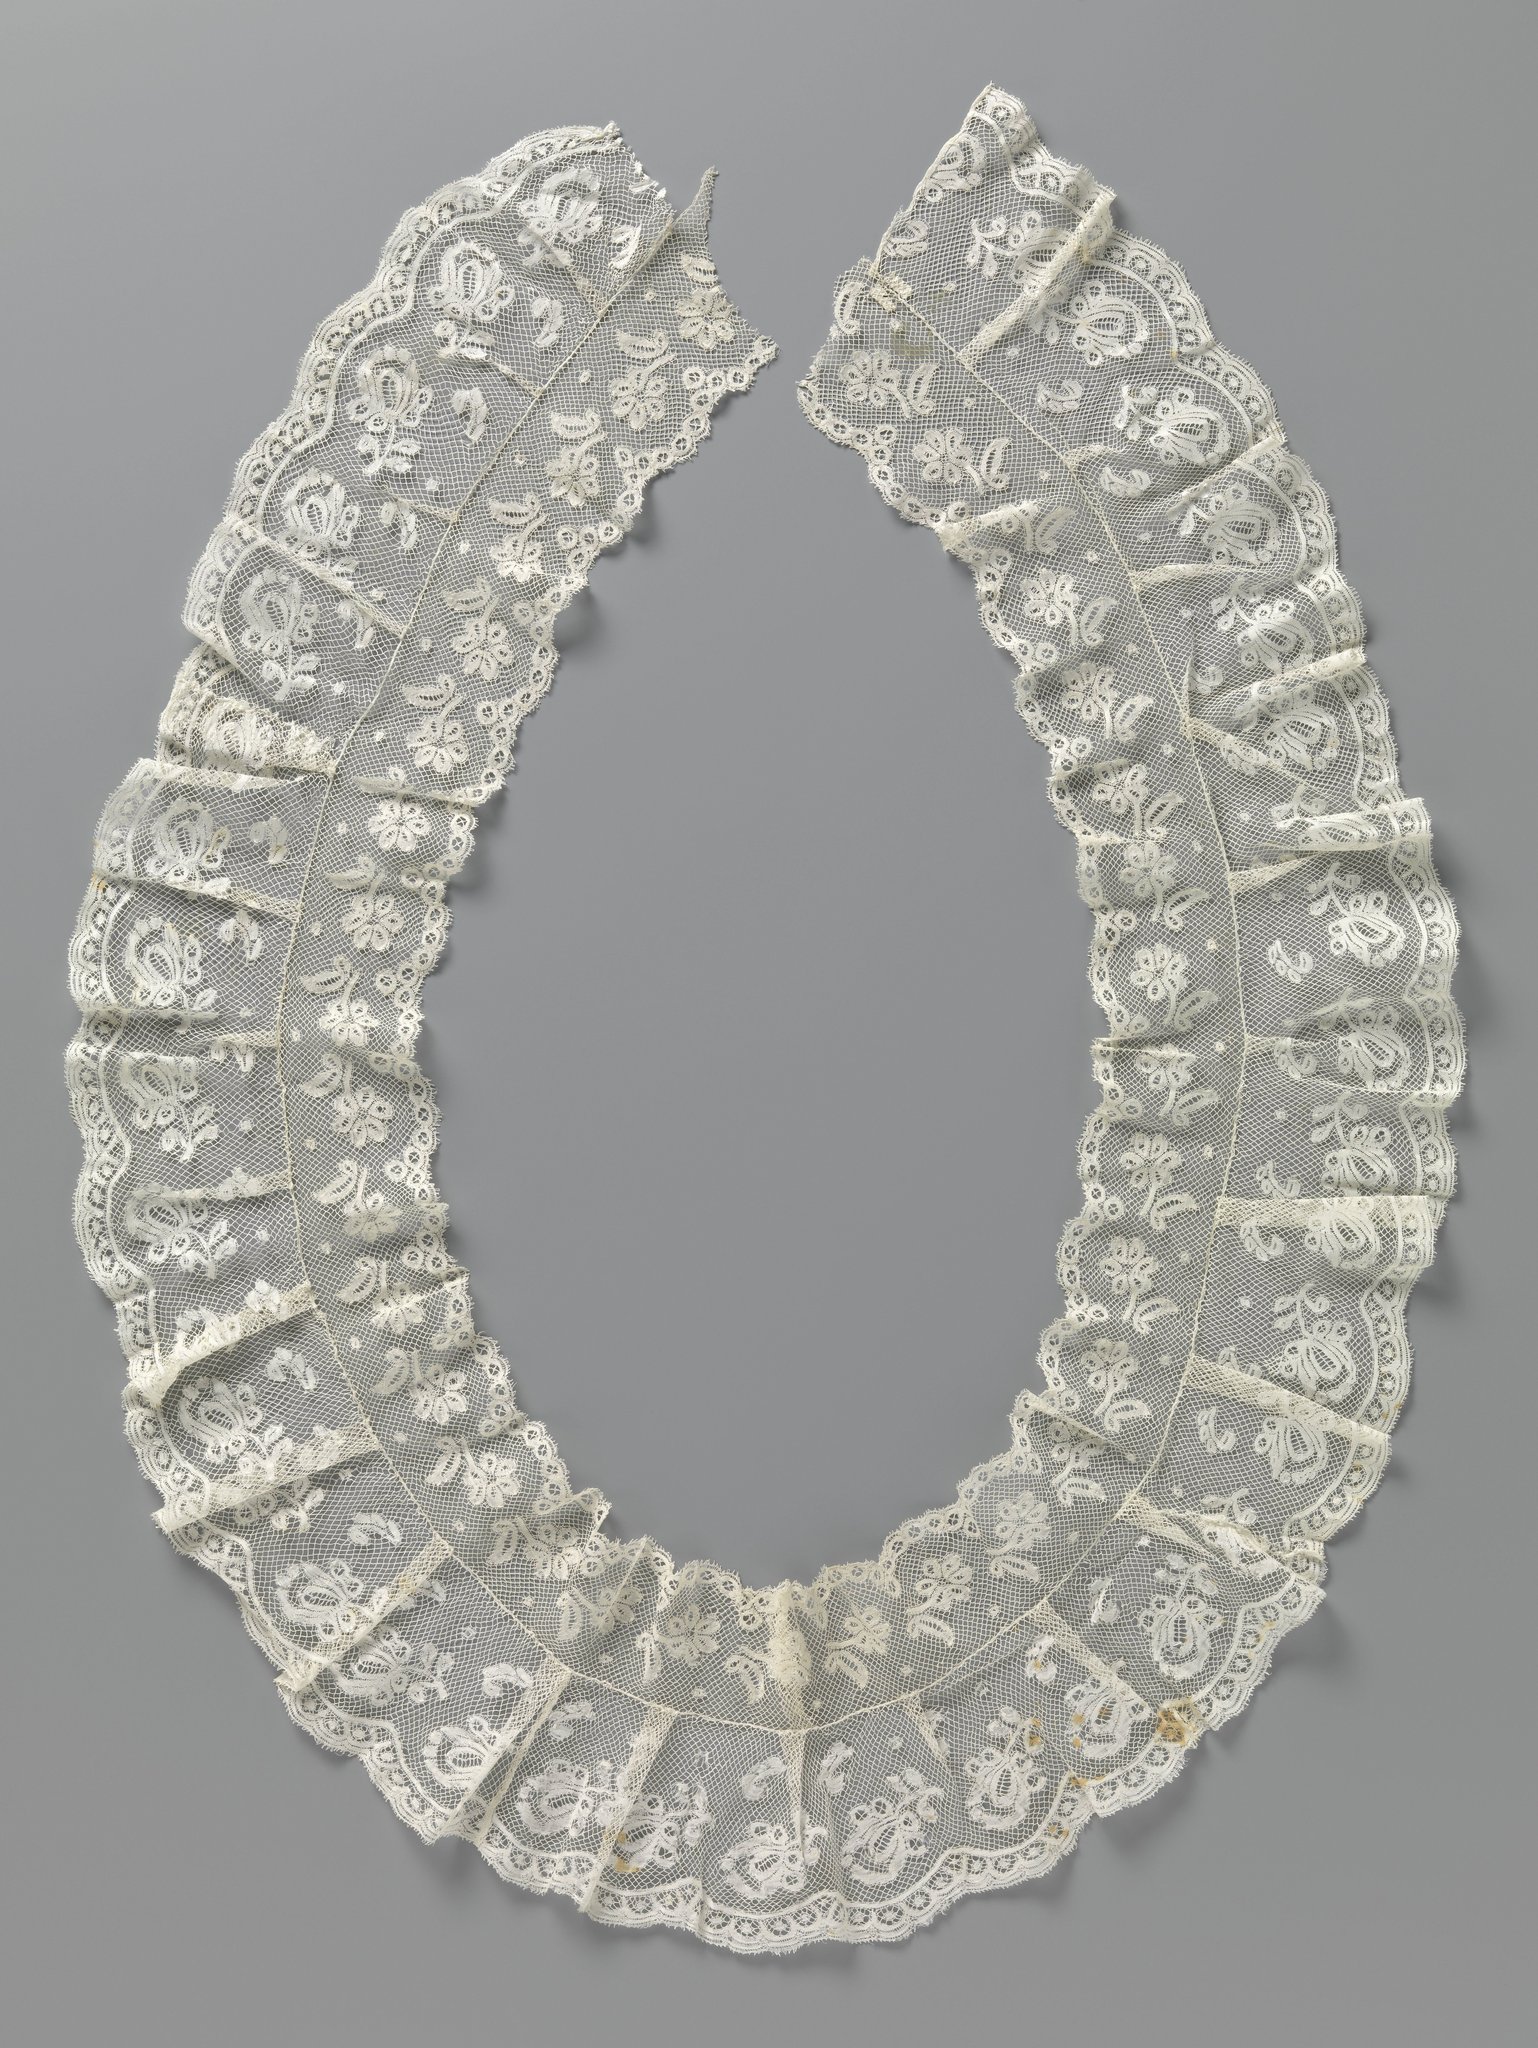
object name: strip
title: Verdubbelde strook kloskant met margrietjes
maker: Anonymous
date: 1900-1924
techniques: lace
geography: sluis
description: De strook met margrietjes bestond volgens de catalogus 'Kant uit Koninklijk bezit' uit drie losse delen en had één inventarisnummer: J-272. Mogelijk voor een tentoonstelling zijn hier echter meerdere delen van gemaakt of zijn er juist delen aan elkaar genaaid of vermaakt tot een kraag en manchetten. Aan de verschillende delen zijn subnummers toegekend. De totale lengte van deze stroken bij elkaar is om onduidelijke redenen langer dan de in de catalogus aangegeven totaallengte van J-272.